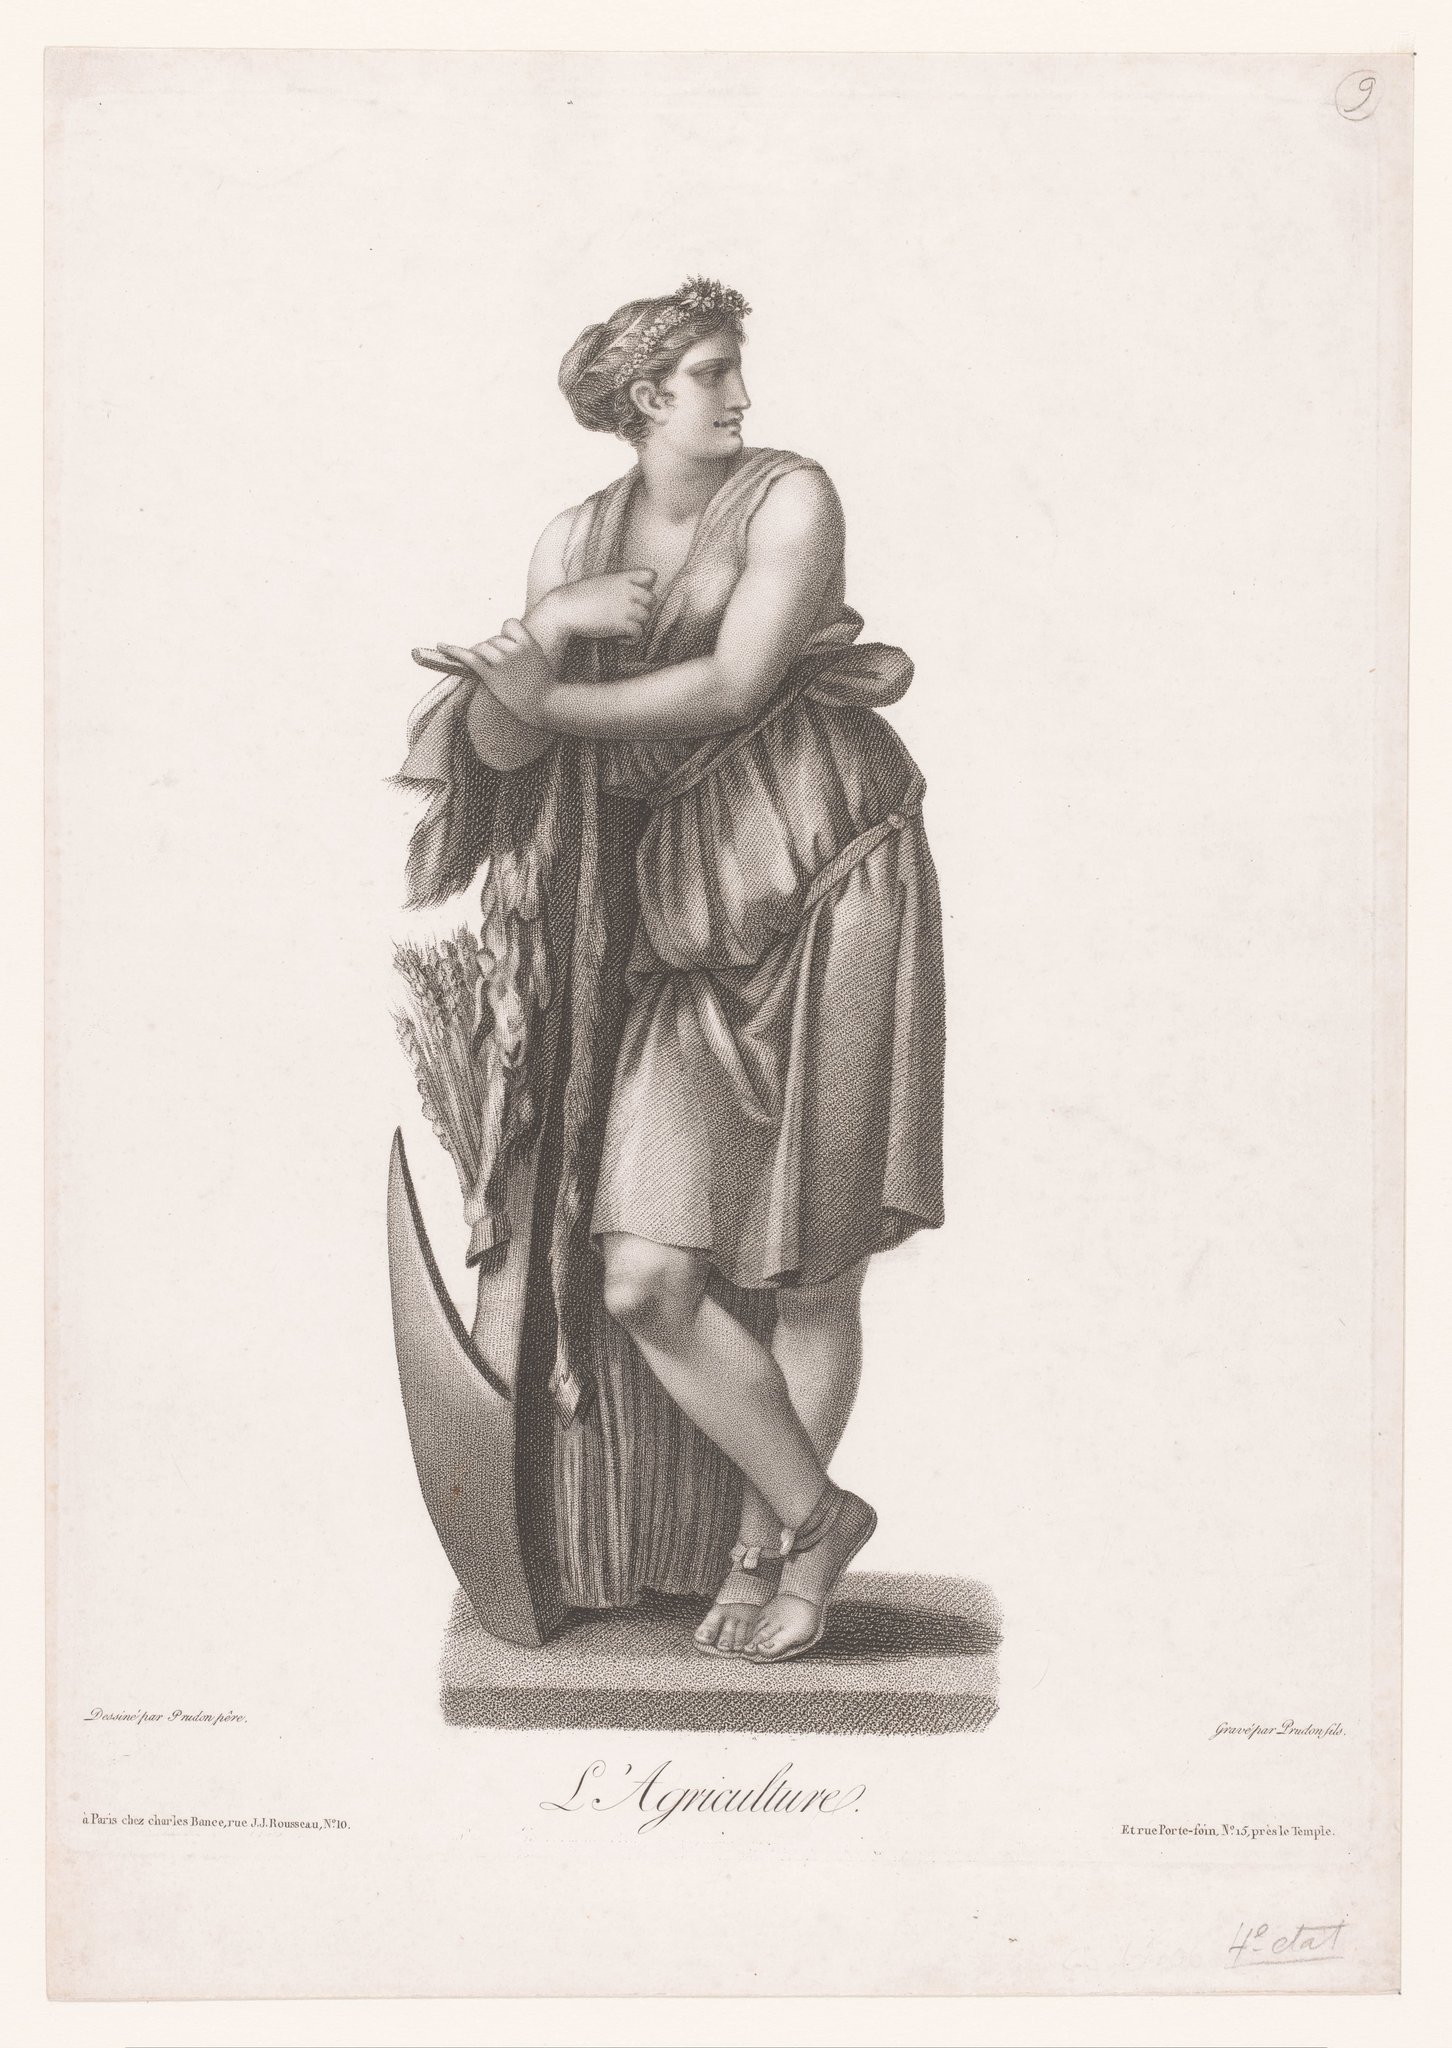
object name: print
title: Landbouw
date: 1810-1823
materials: paper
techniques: engraving, etching, roulette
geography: paris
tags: personification of agriculture, 'agricultura'; 'agricoltura', 'studio dell'agricoltura' (ripa)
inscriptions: collector's mark: Lugt 2228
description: Serie naar de figuren die als decoratie gebruikt zijn in het stadhuis, tijdens het huwelijk van Napoleon I Bonaparte en Marie Louise van Oostenrijk in 1810.